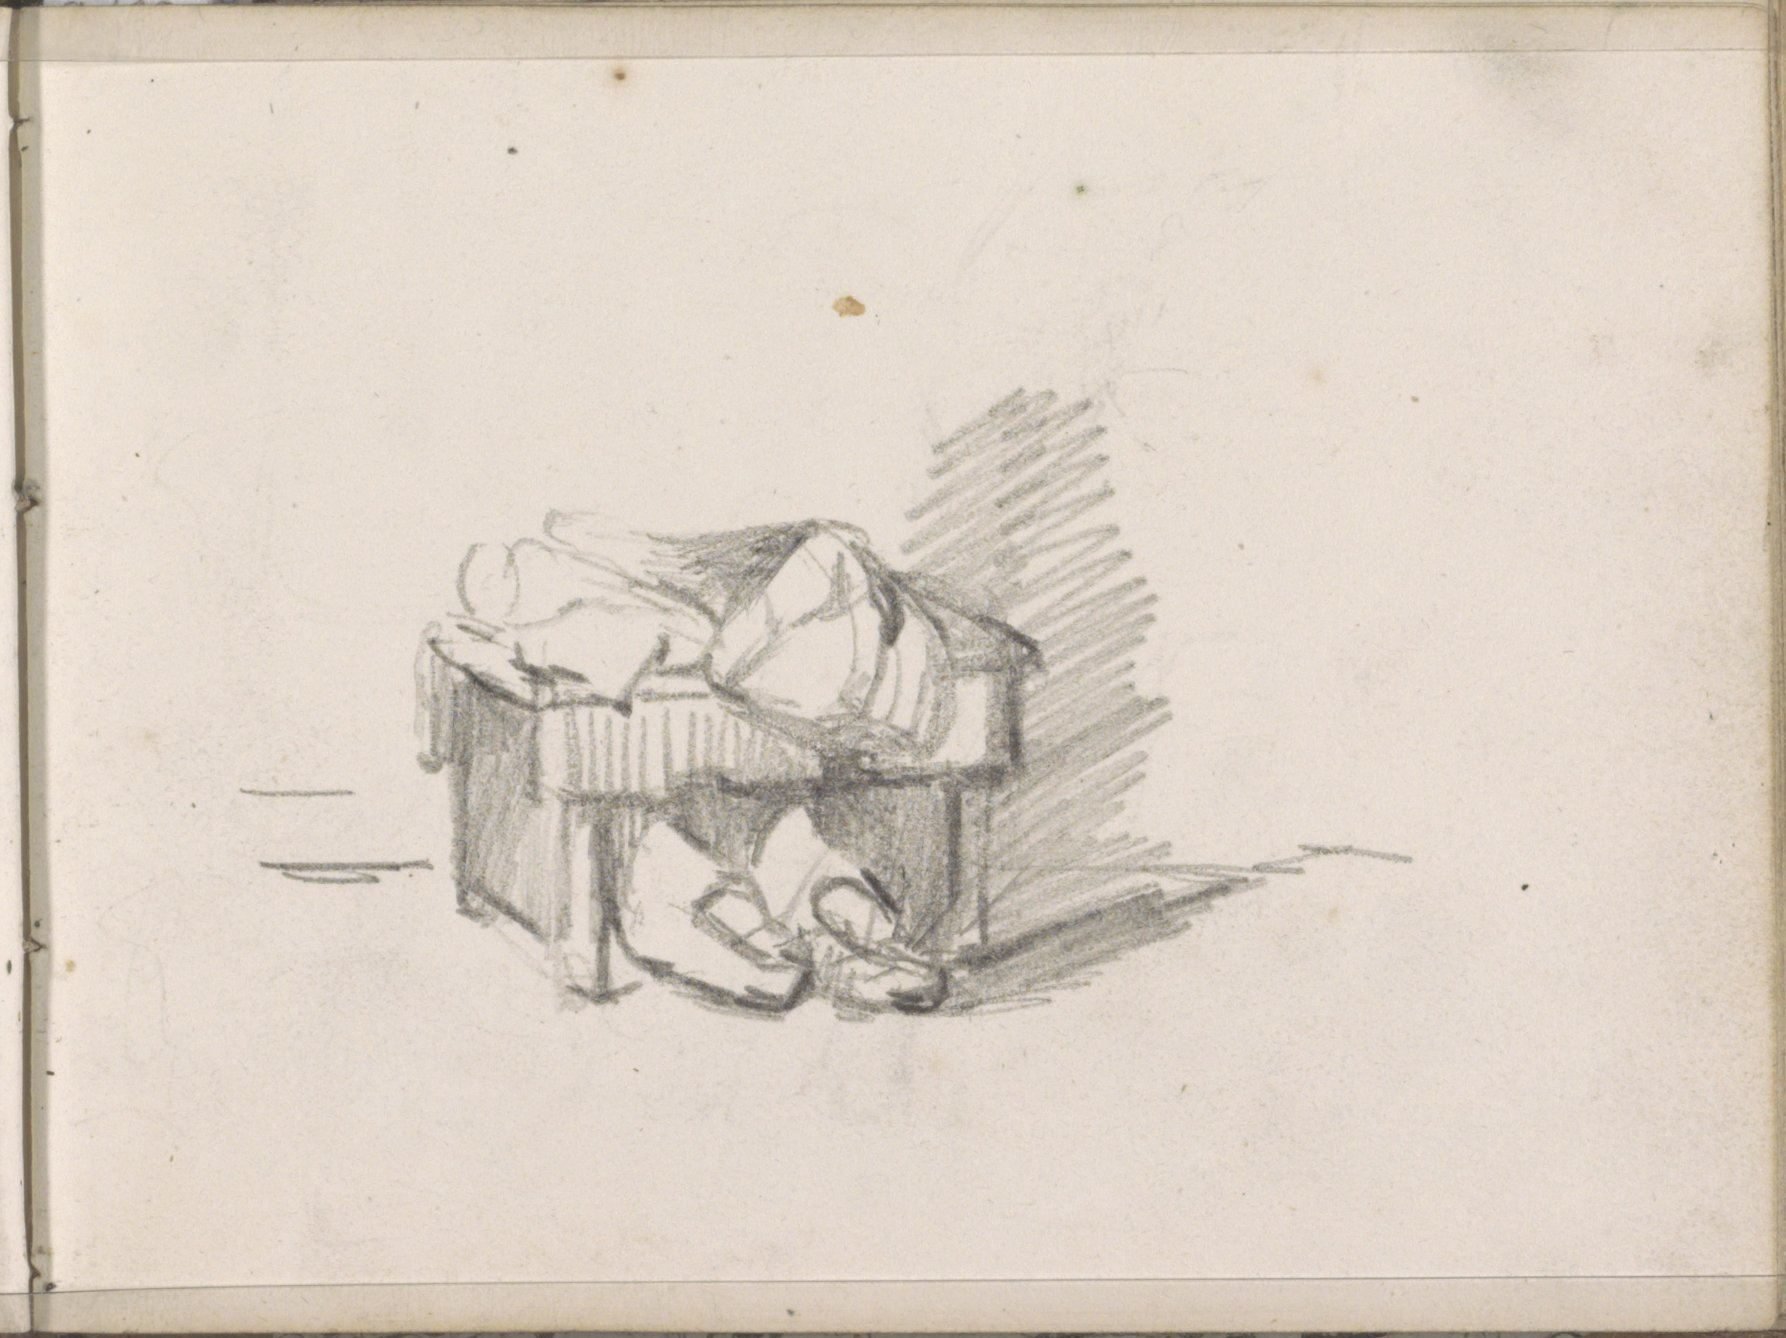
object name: sketchbook leaf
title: Sloffen onder een voetenbank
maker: maria vos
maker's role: draughtsman, painter, print maker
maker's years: 1824-1906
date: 1834-1906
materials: paper, pencil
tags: footstool, slippers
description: Blad 6 recto uit een schetsboek met 21 bladen.